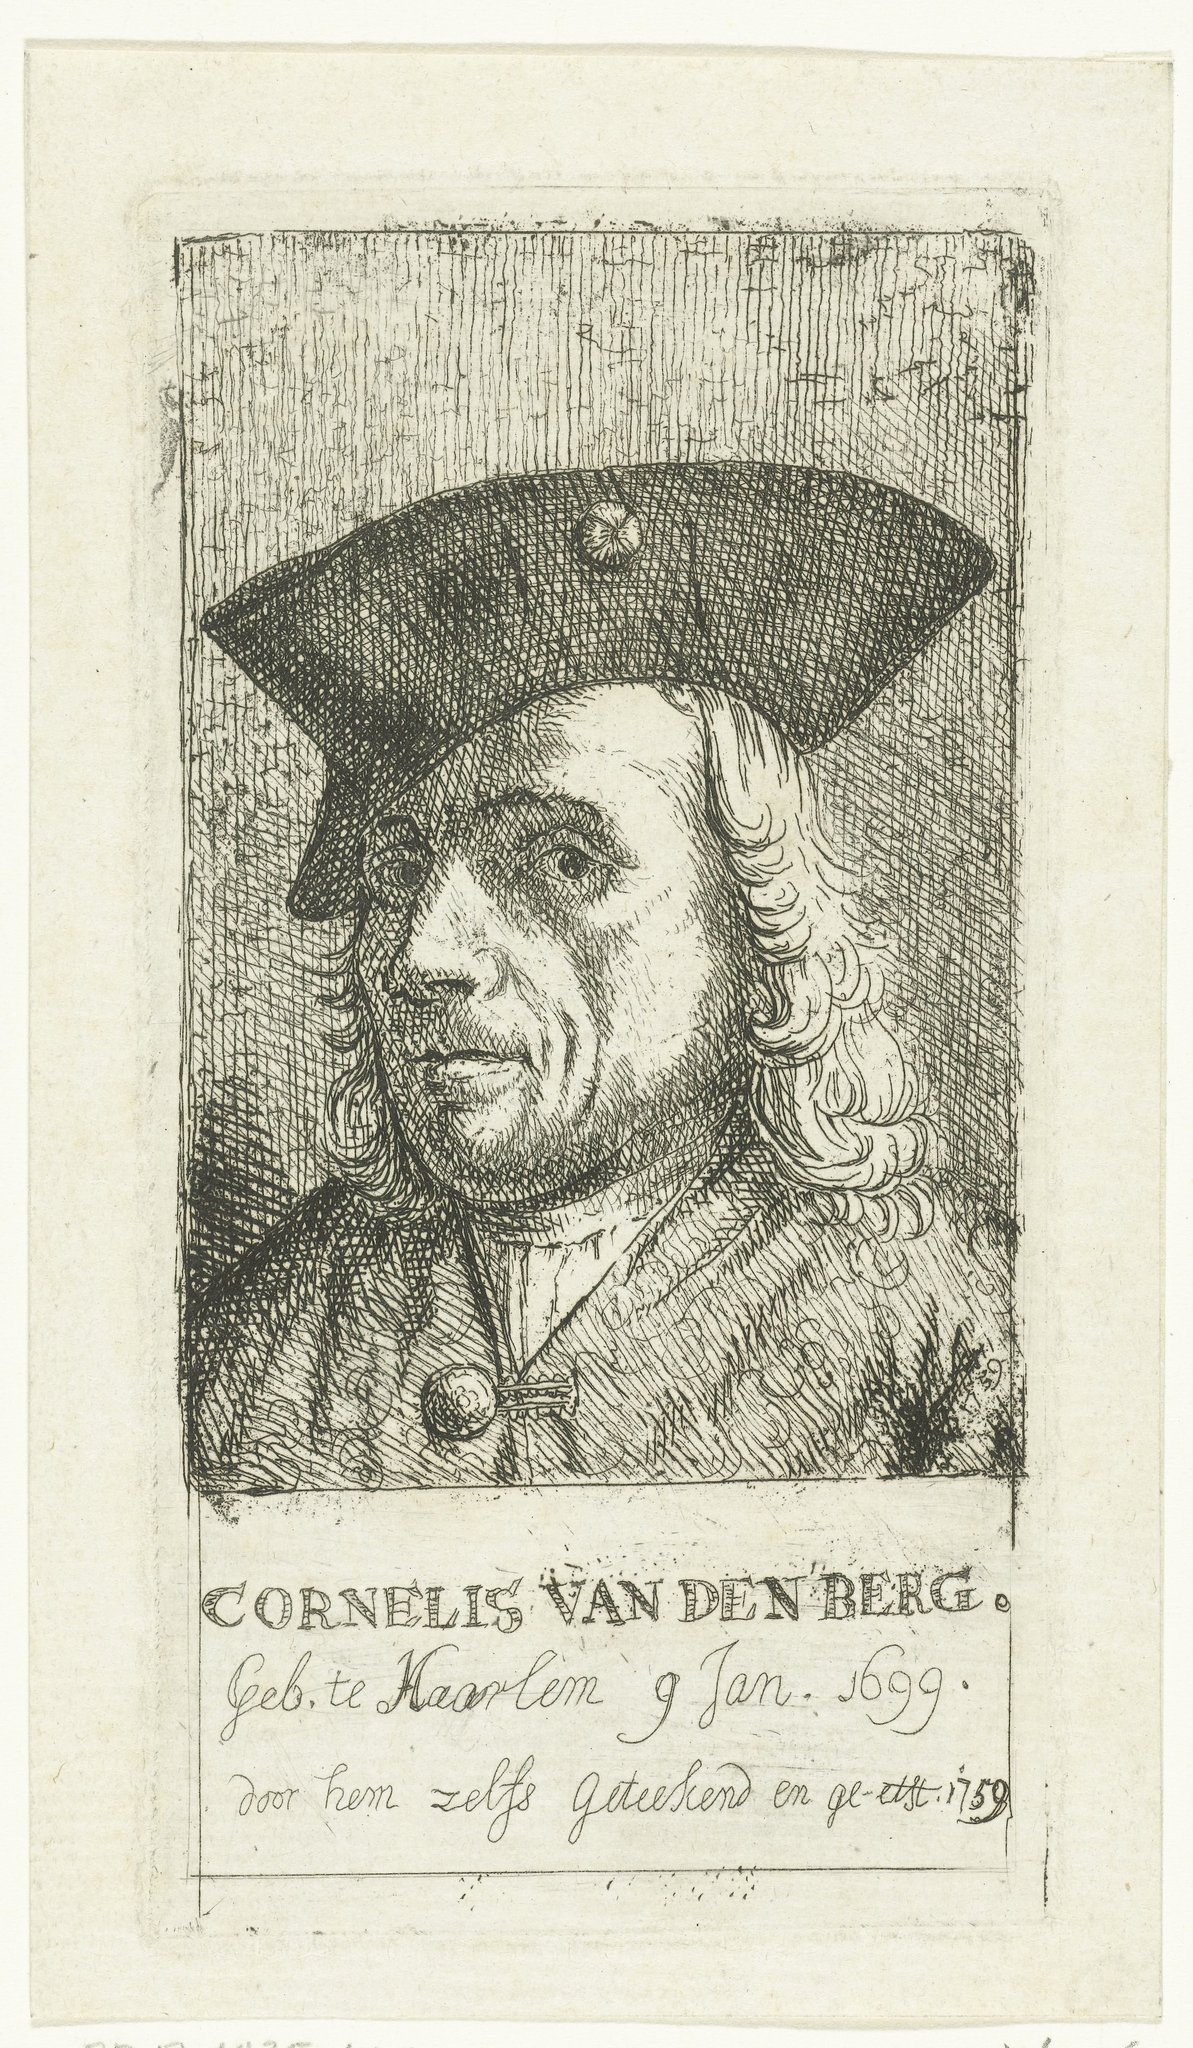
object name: print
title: Cornelis van den Berg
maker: cornelis van den berg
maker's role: draughtsman, print maker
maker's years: 1699-1774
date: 1759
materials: paper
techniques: etching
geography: haarlem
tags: haarlem, cornelis van den berg, portrait, self-portrait of painter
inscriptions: collector's mark: Lugt 2760, collector's mark: Lugt 2228